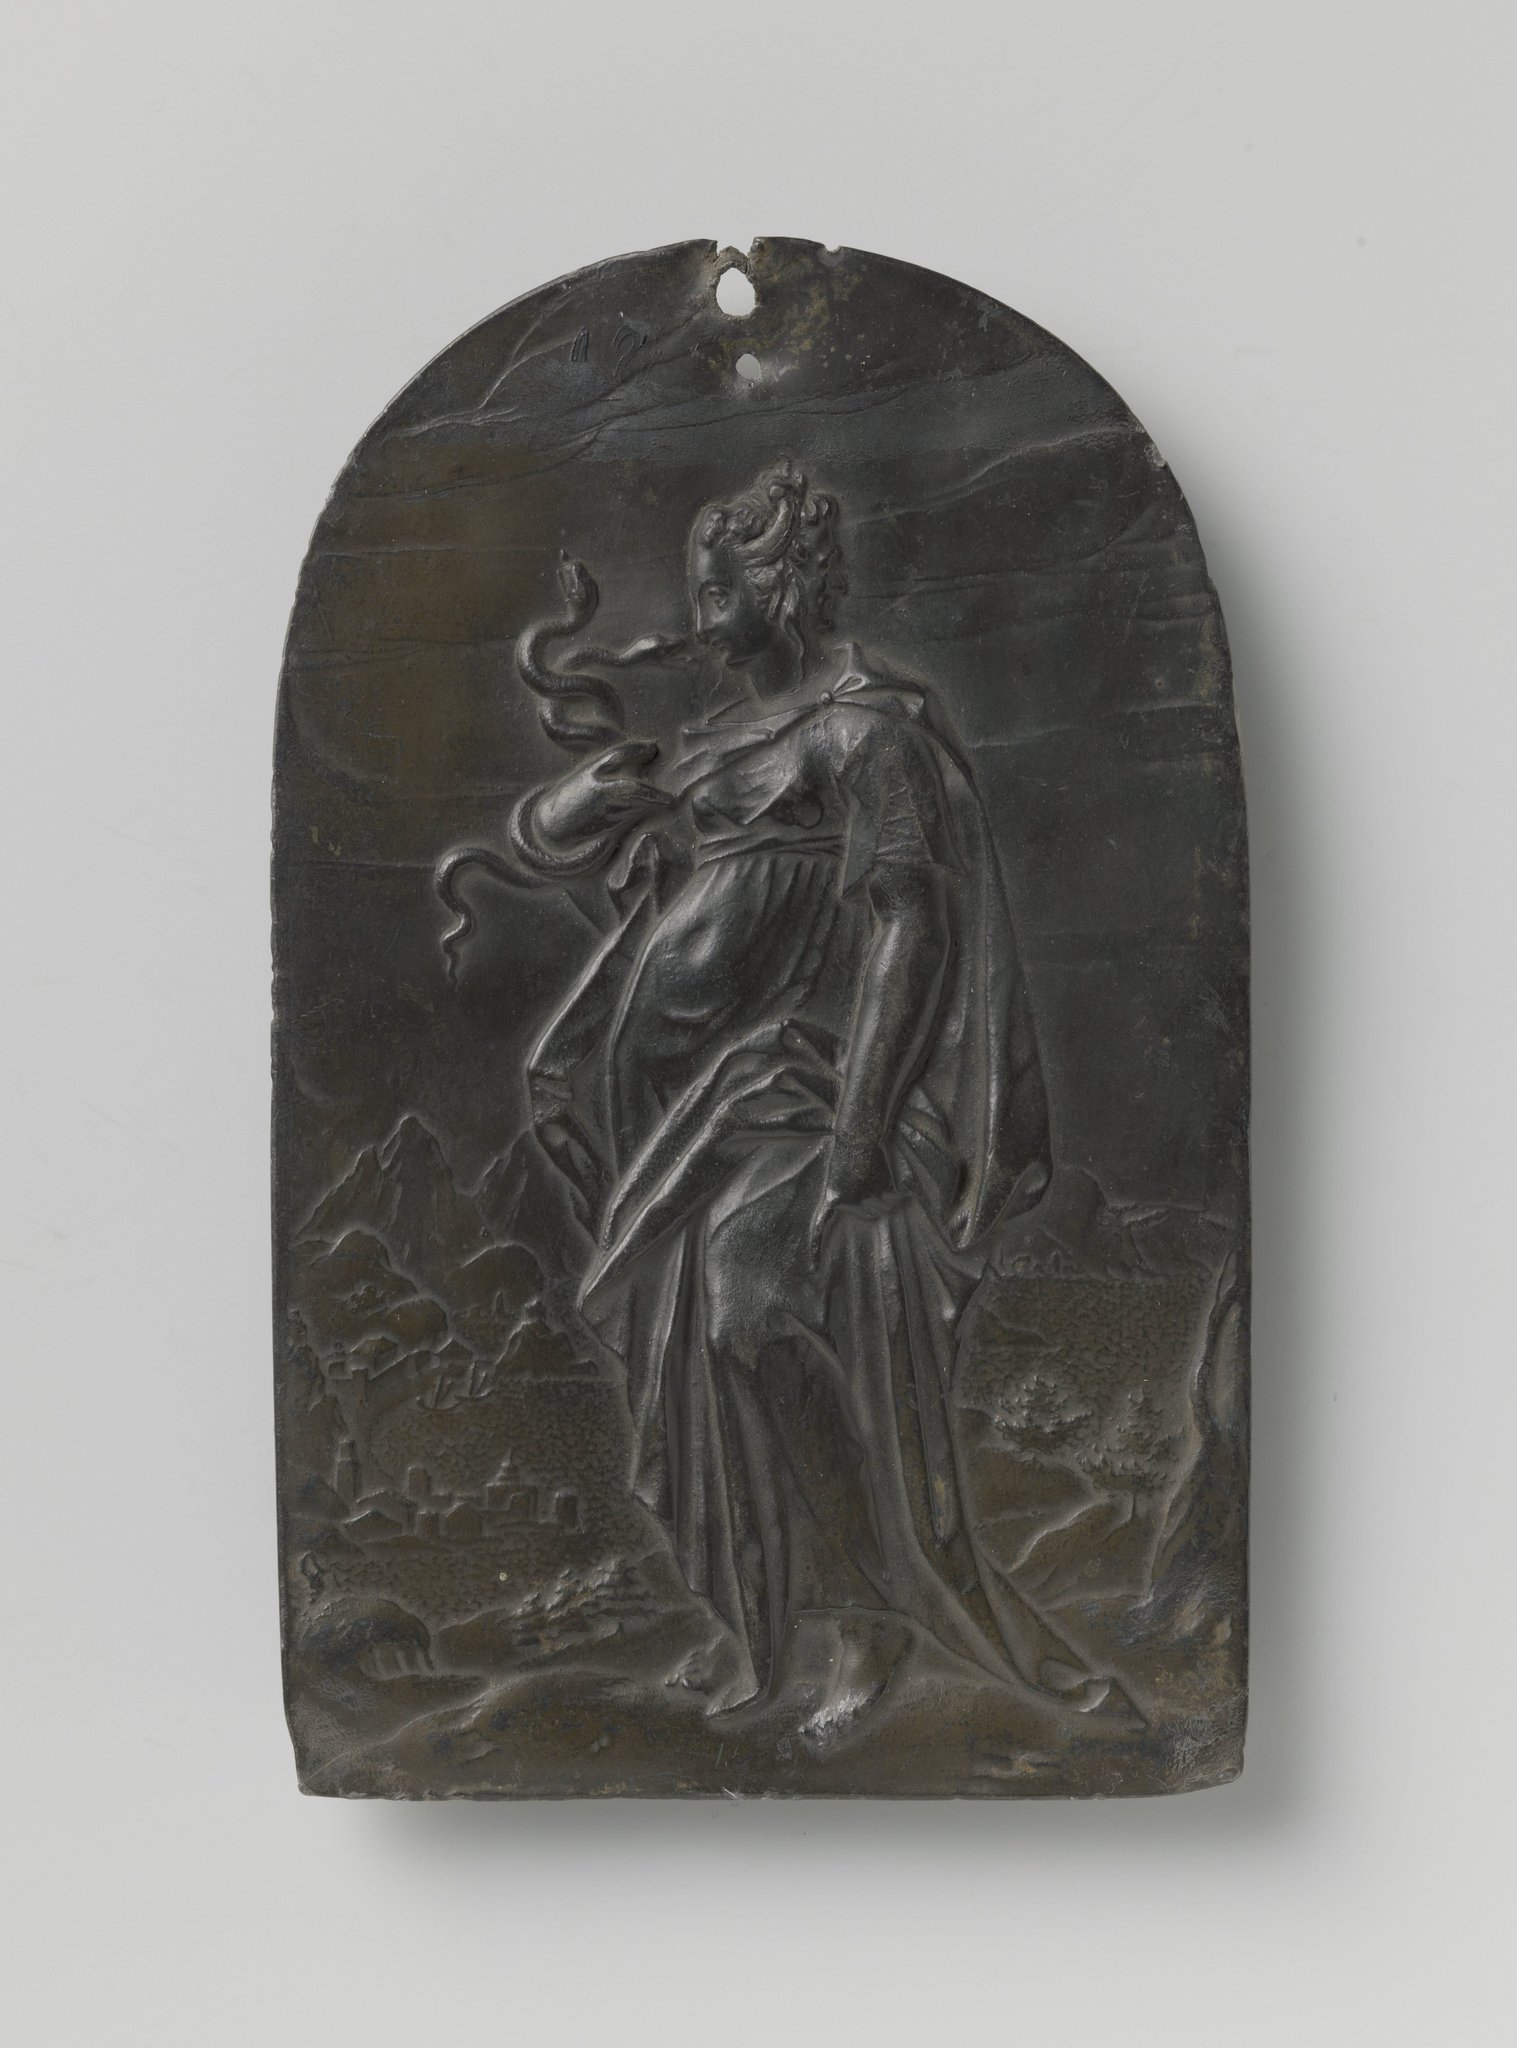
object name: plaque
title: Prudentia (Wijsheid)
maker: Anonymous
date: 1600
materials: lead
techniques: casting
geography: netherlands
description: Langwerpige, van boven afgeronde, loden plaquette met zinnebeeldige vrouwenfiguur met attribuut voorstellende Prudentia (Wijsheid). Voor een boomrijk rivierlandschap staat een vrouw met Januskop met omgord gewaad, dat met de linkerarm wordt opgehouden, naar links gekeerd en kijkt naar de tweekoppige slang in haar rechterhand.